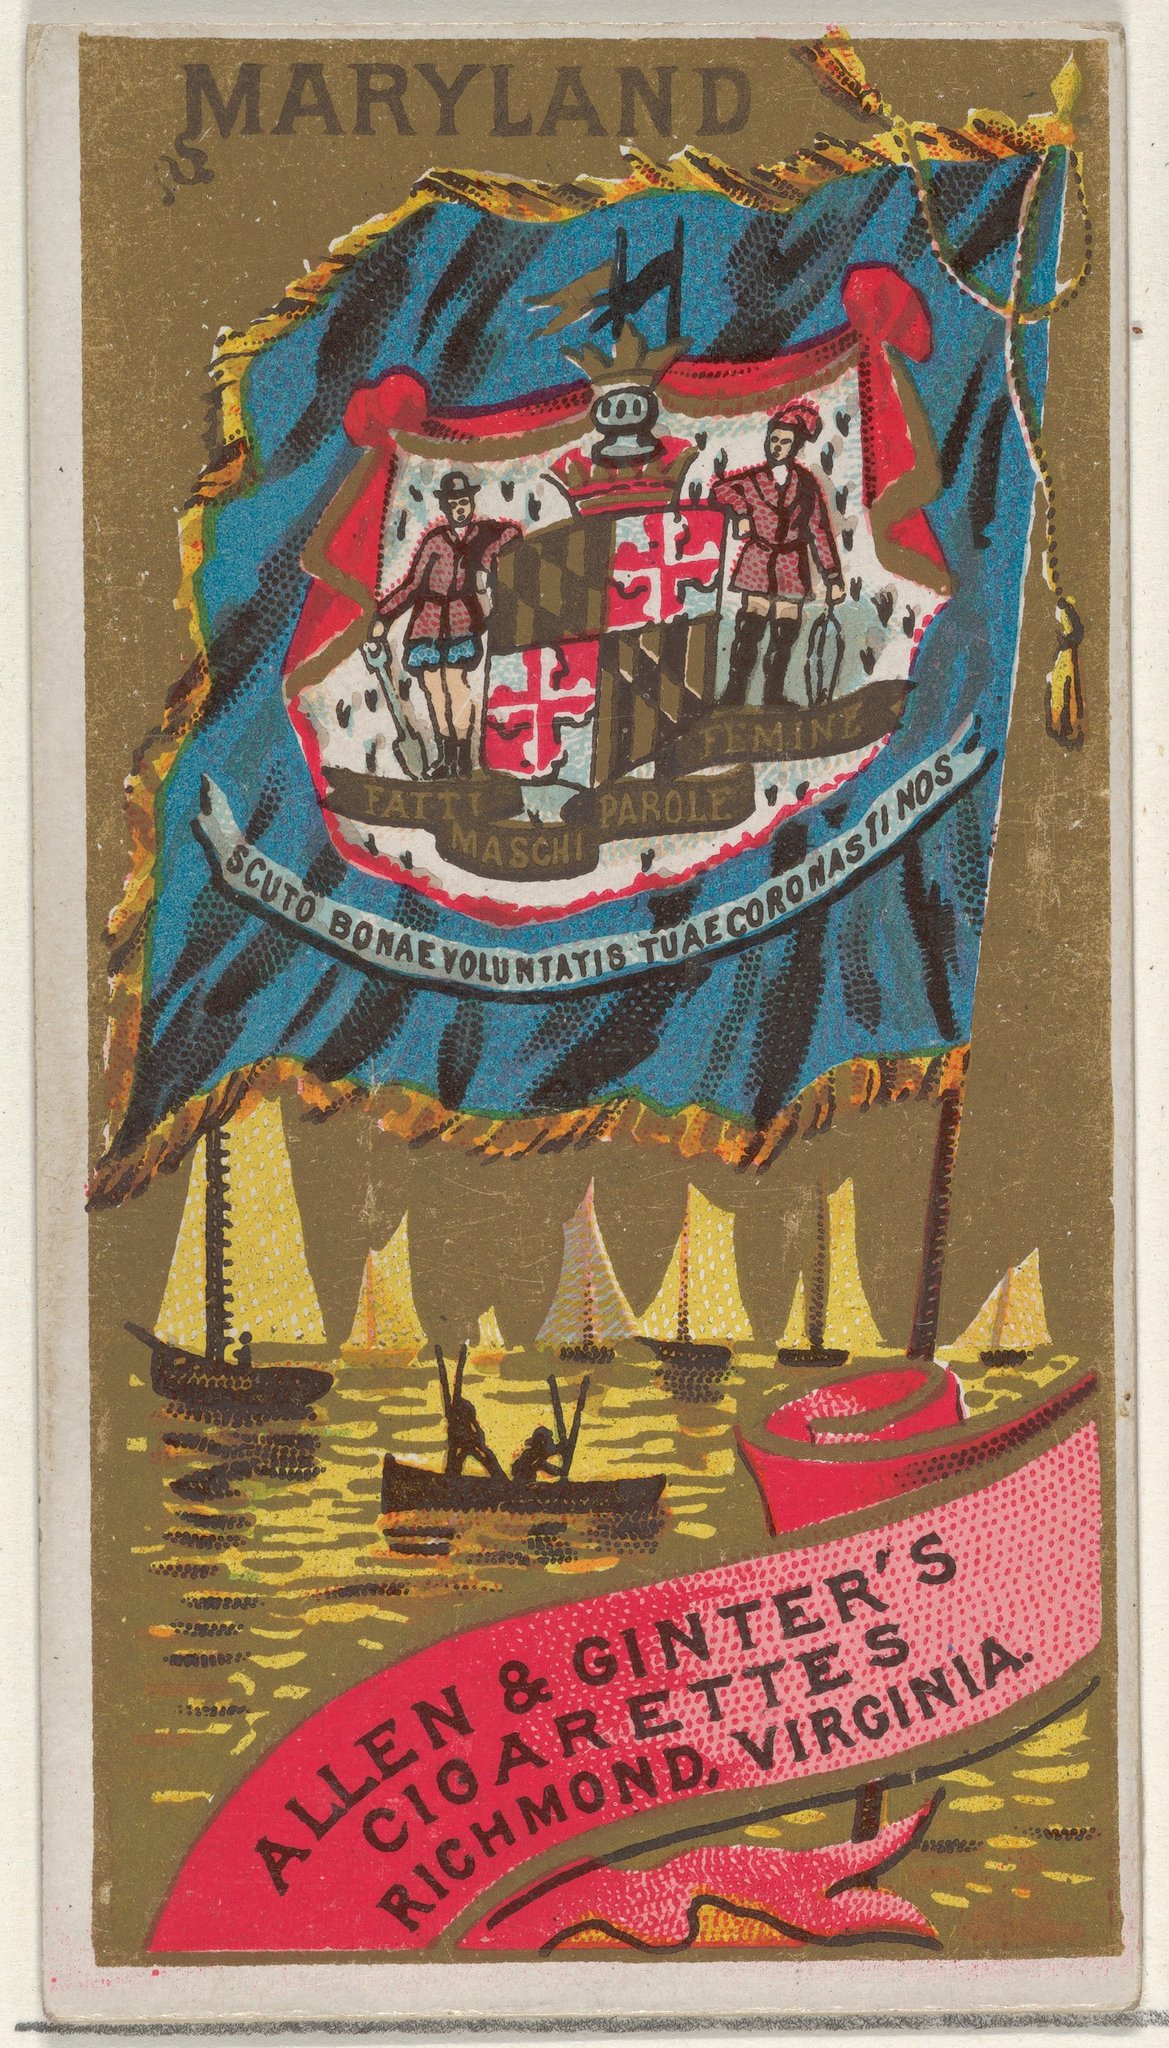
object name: print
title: Maryland, from Flags of the States and Territories (N11) for Allen & Ginter Cigarettes Brands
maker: allen & ginter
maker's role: publisher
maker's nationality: american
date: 1888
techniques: color lithograph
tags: coat of arms,flags